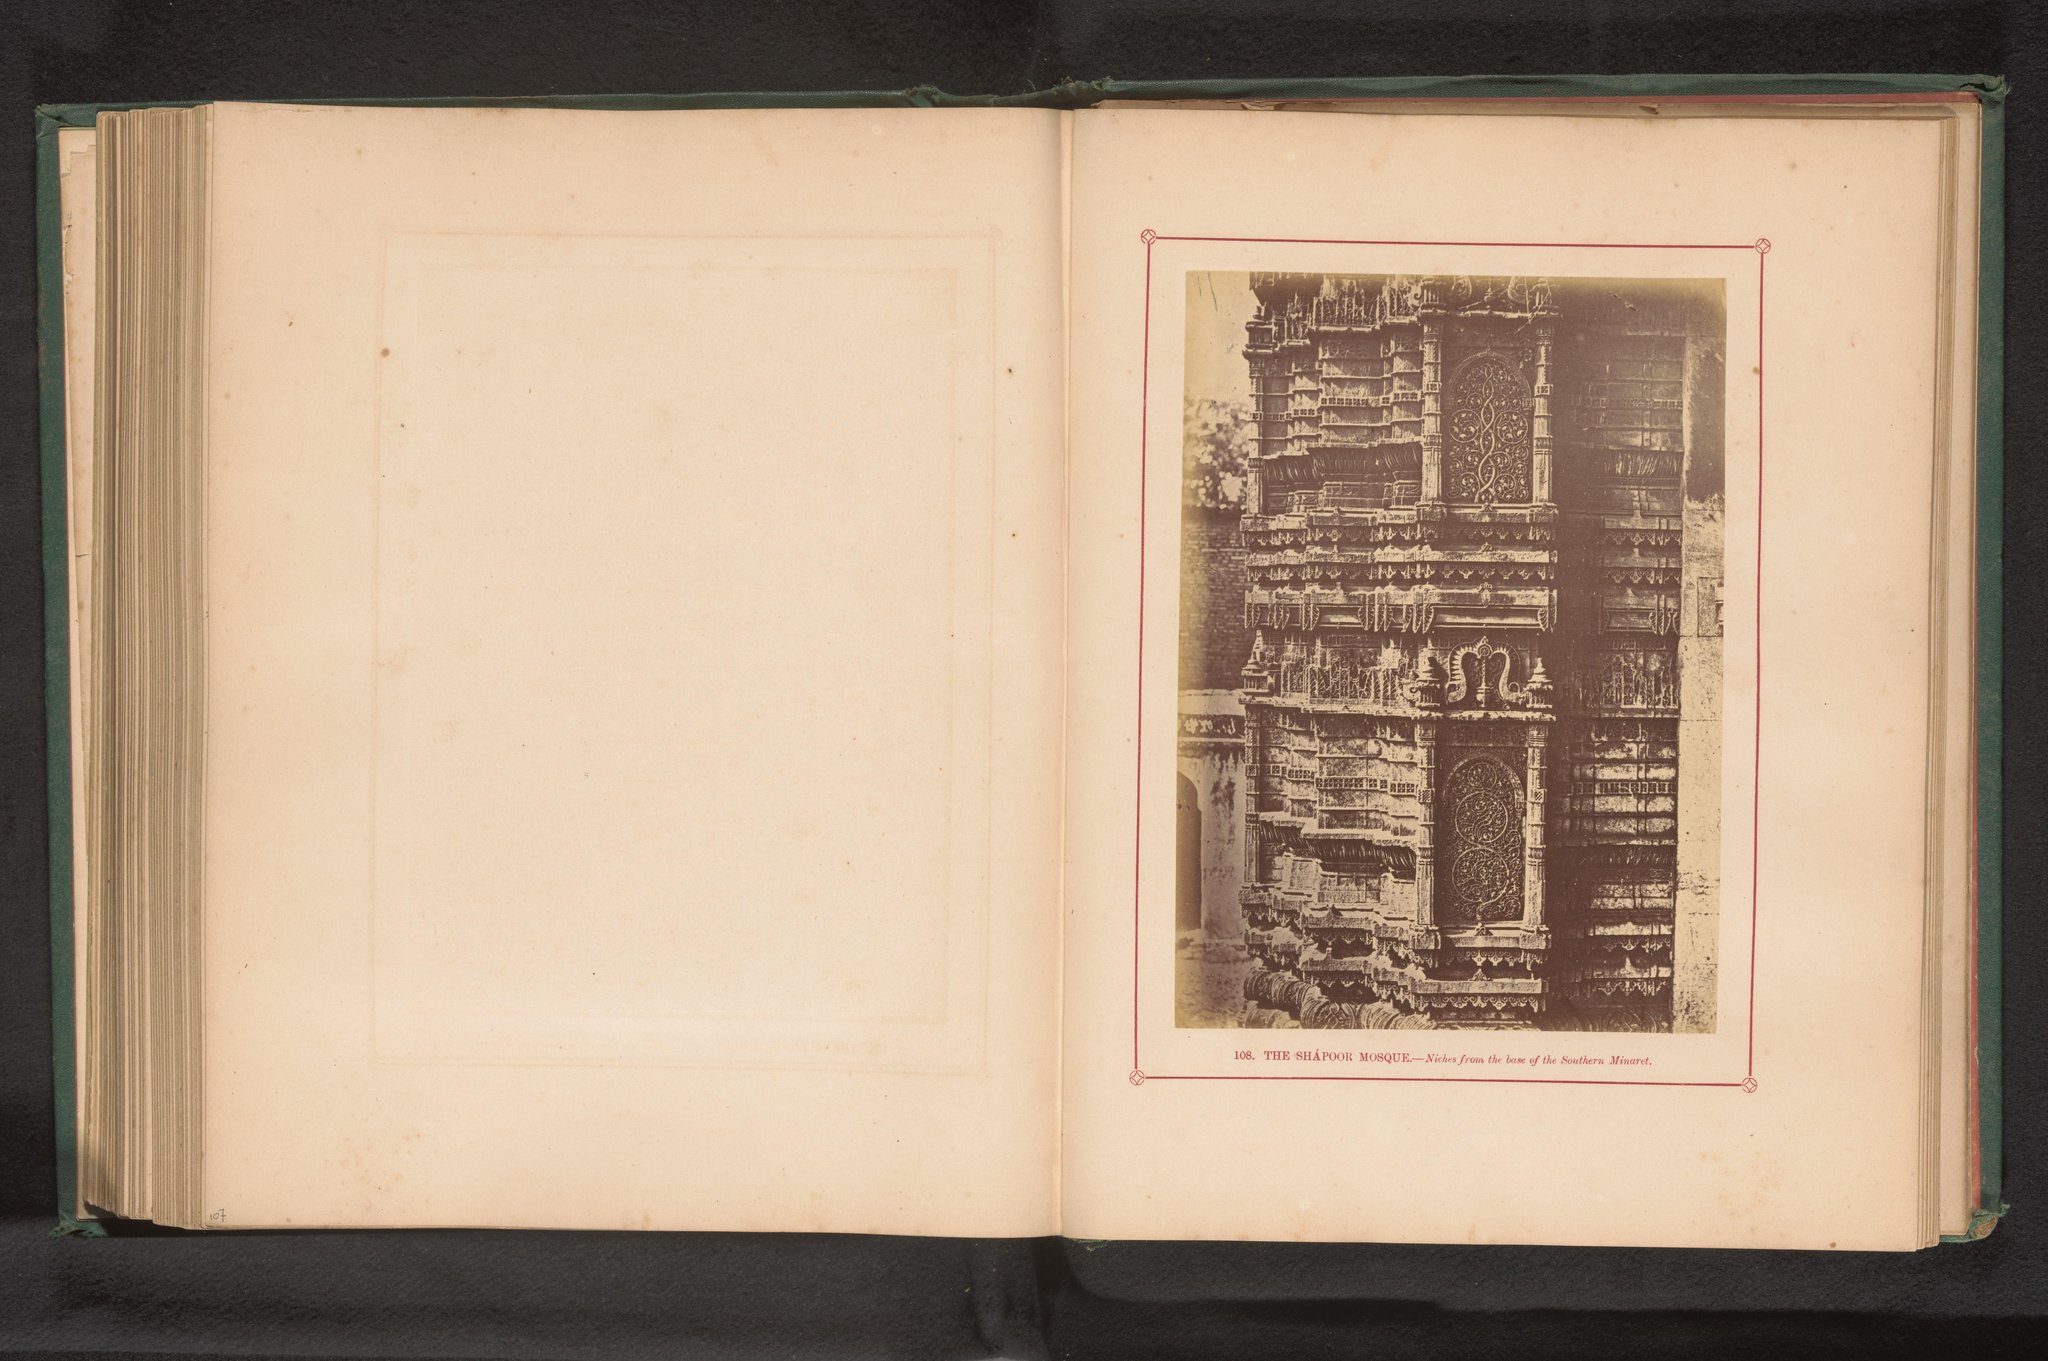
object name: photograph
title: Decoraties op een basement van een minaret van de Shapoor-moskee in Ahmedabad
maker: thomas biggs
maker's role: fotograaf, kapitein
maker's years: 1822-1905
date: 1856-1866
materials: photographic support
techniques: albumen print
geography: ahmedabad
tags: temple, shrine ~ islam, mohammedanism, base (~ column, pillar)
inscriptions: number: ‘108.’